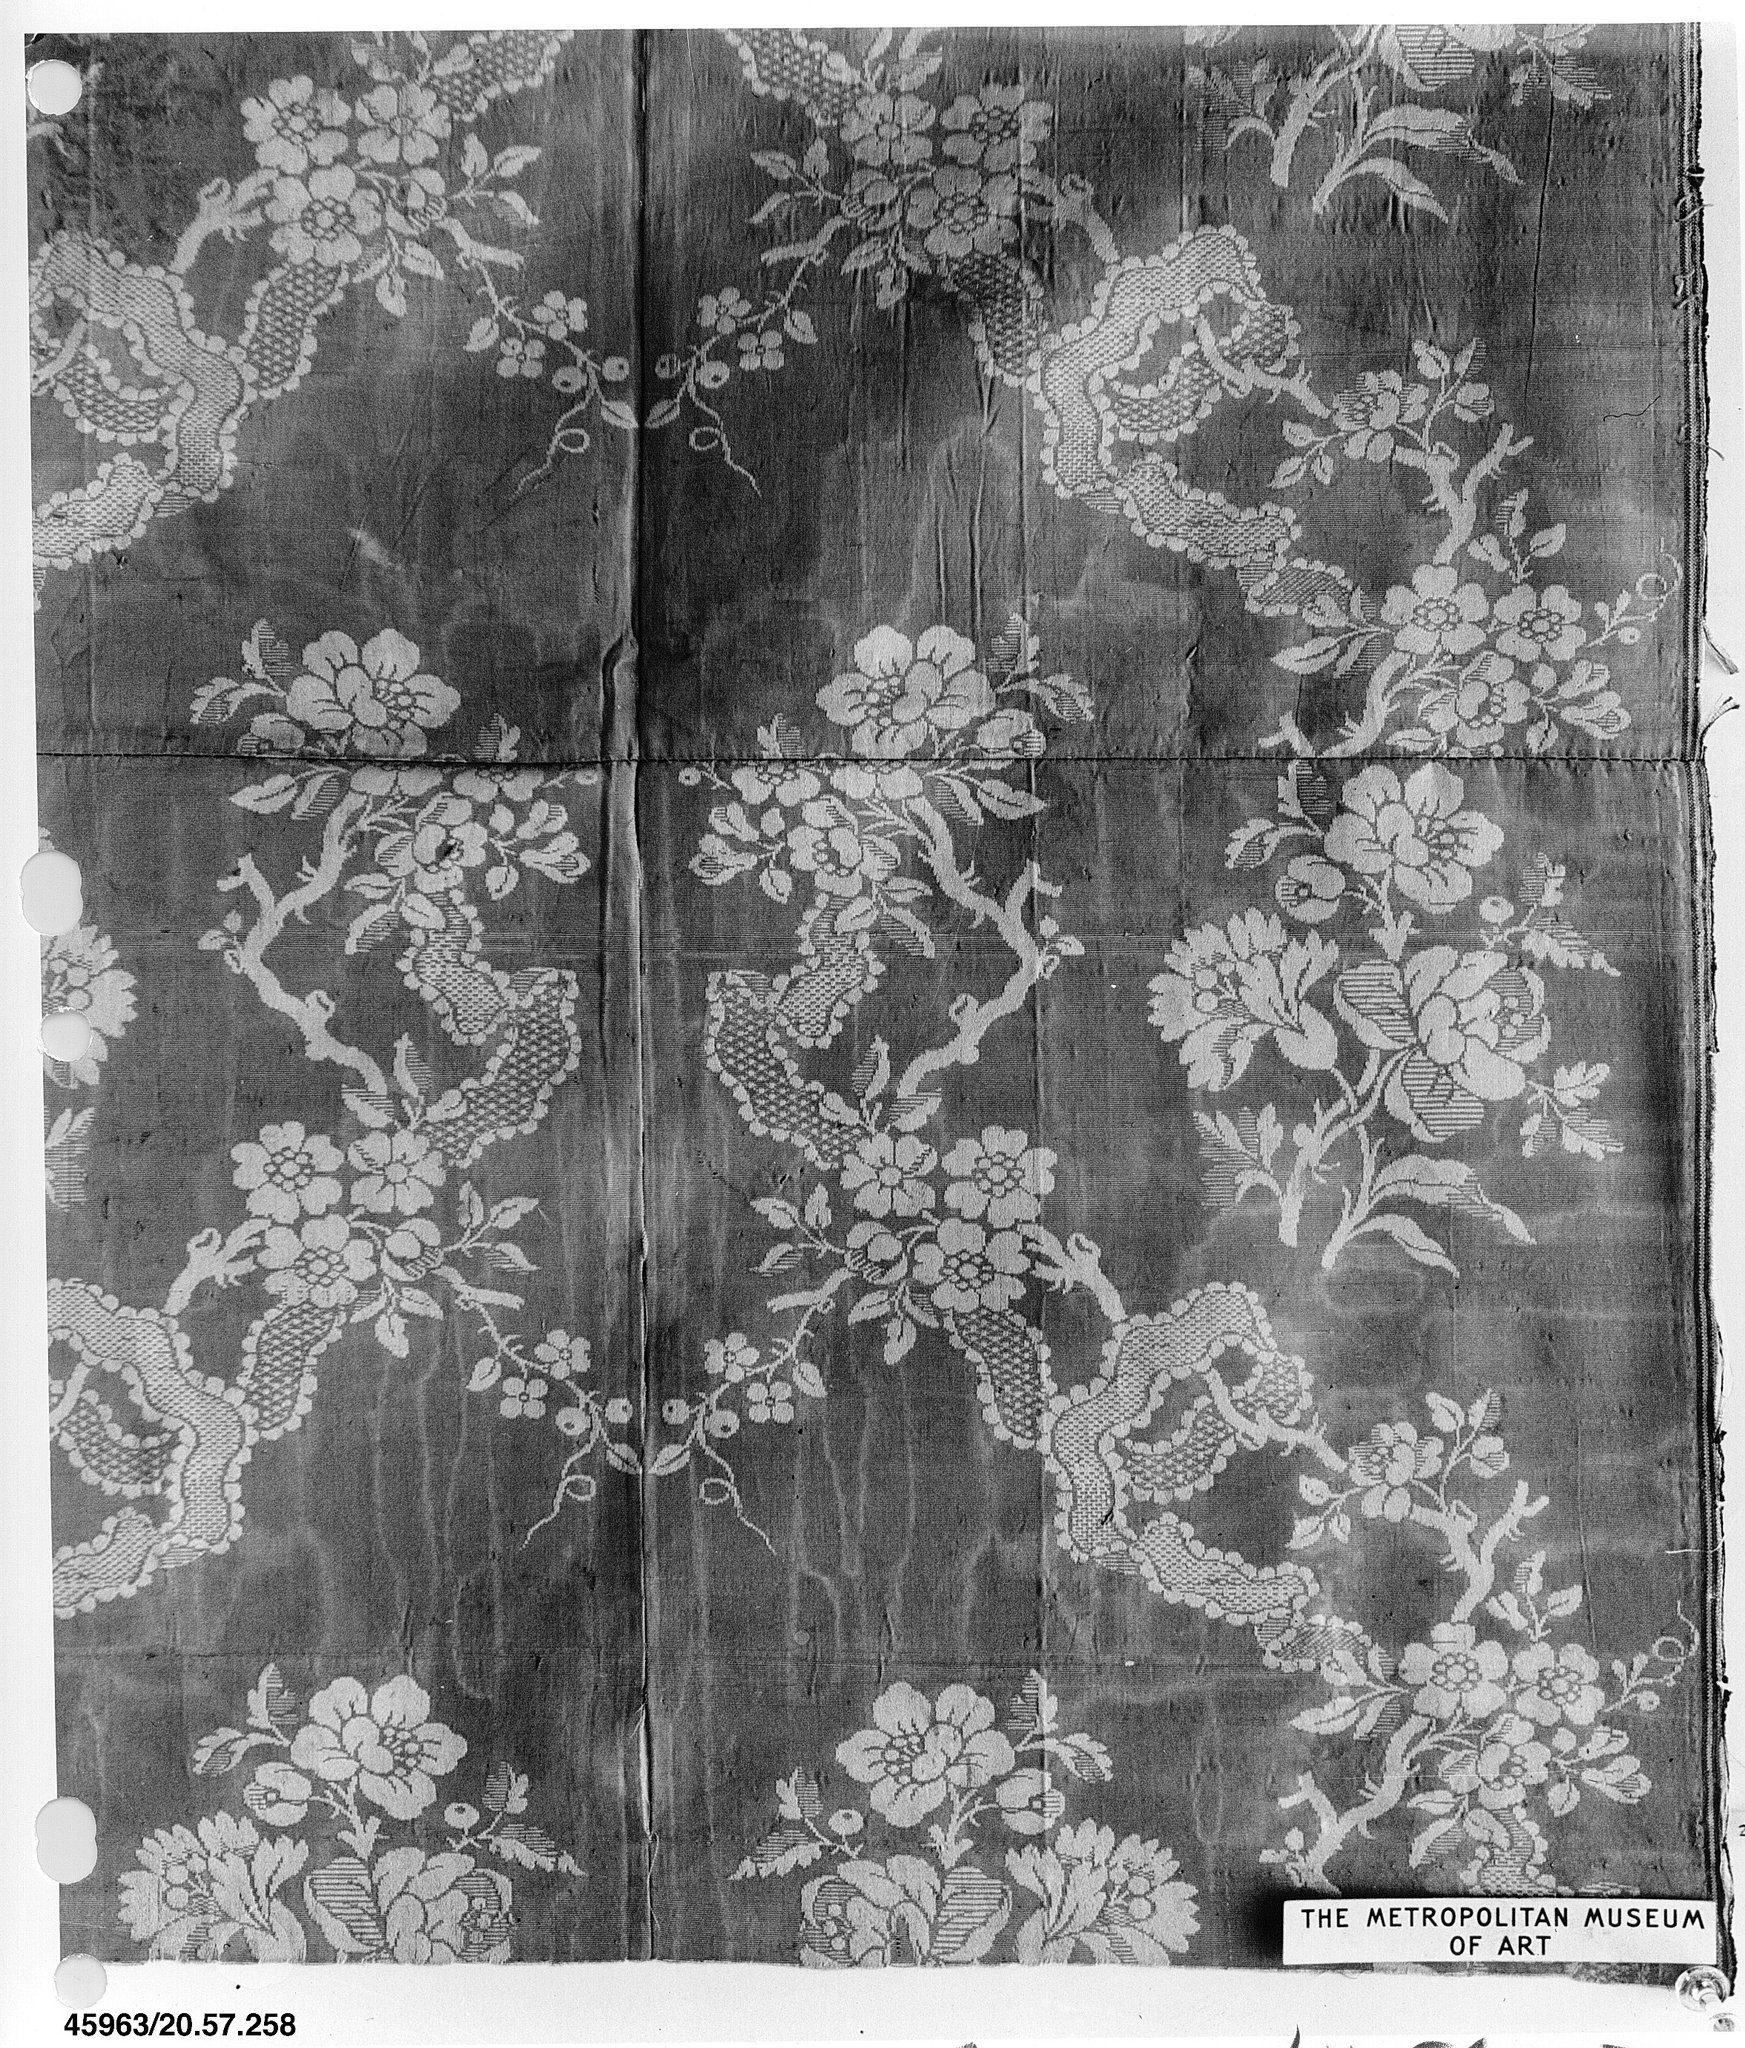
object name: piece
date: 1750-1760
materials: silk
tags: flowers,leaves